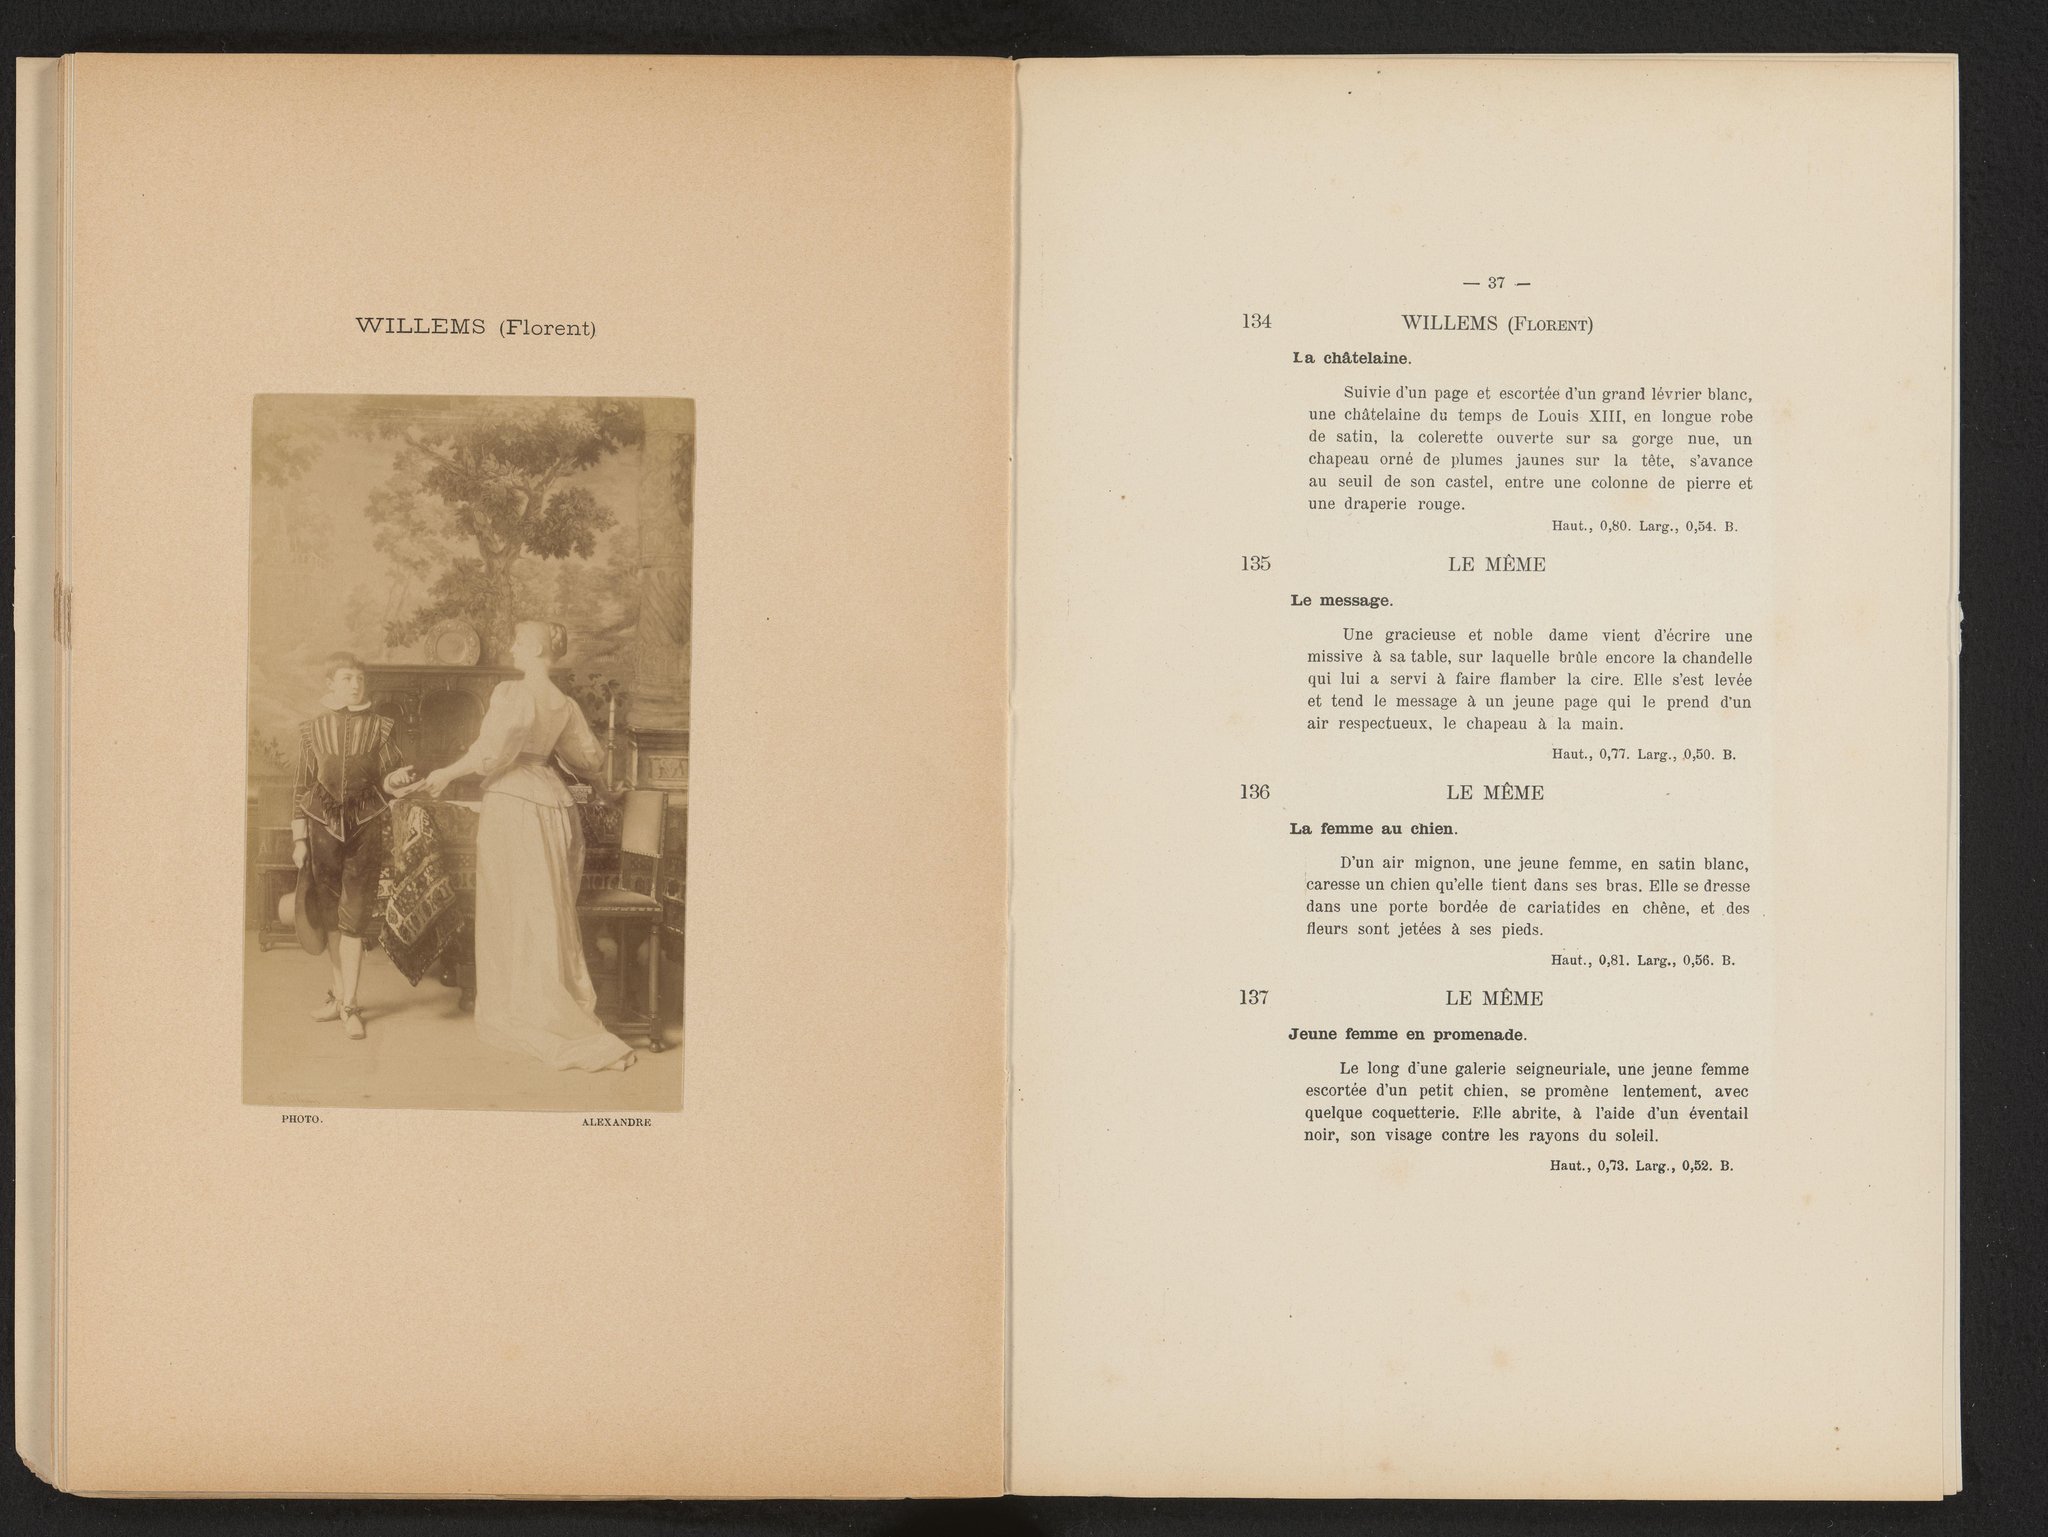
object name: page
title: Willems (Florent)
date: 1888-1893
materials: photographic support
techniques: albumen print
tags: boy (child between toddler and youth), adult man, painting, drawing and the graphic arts